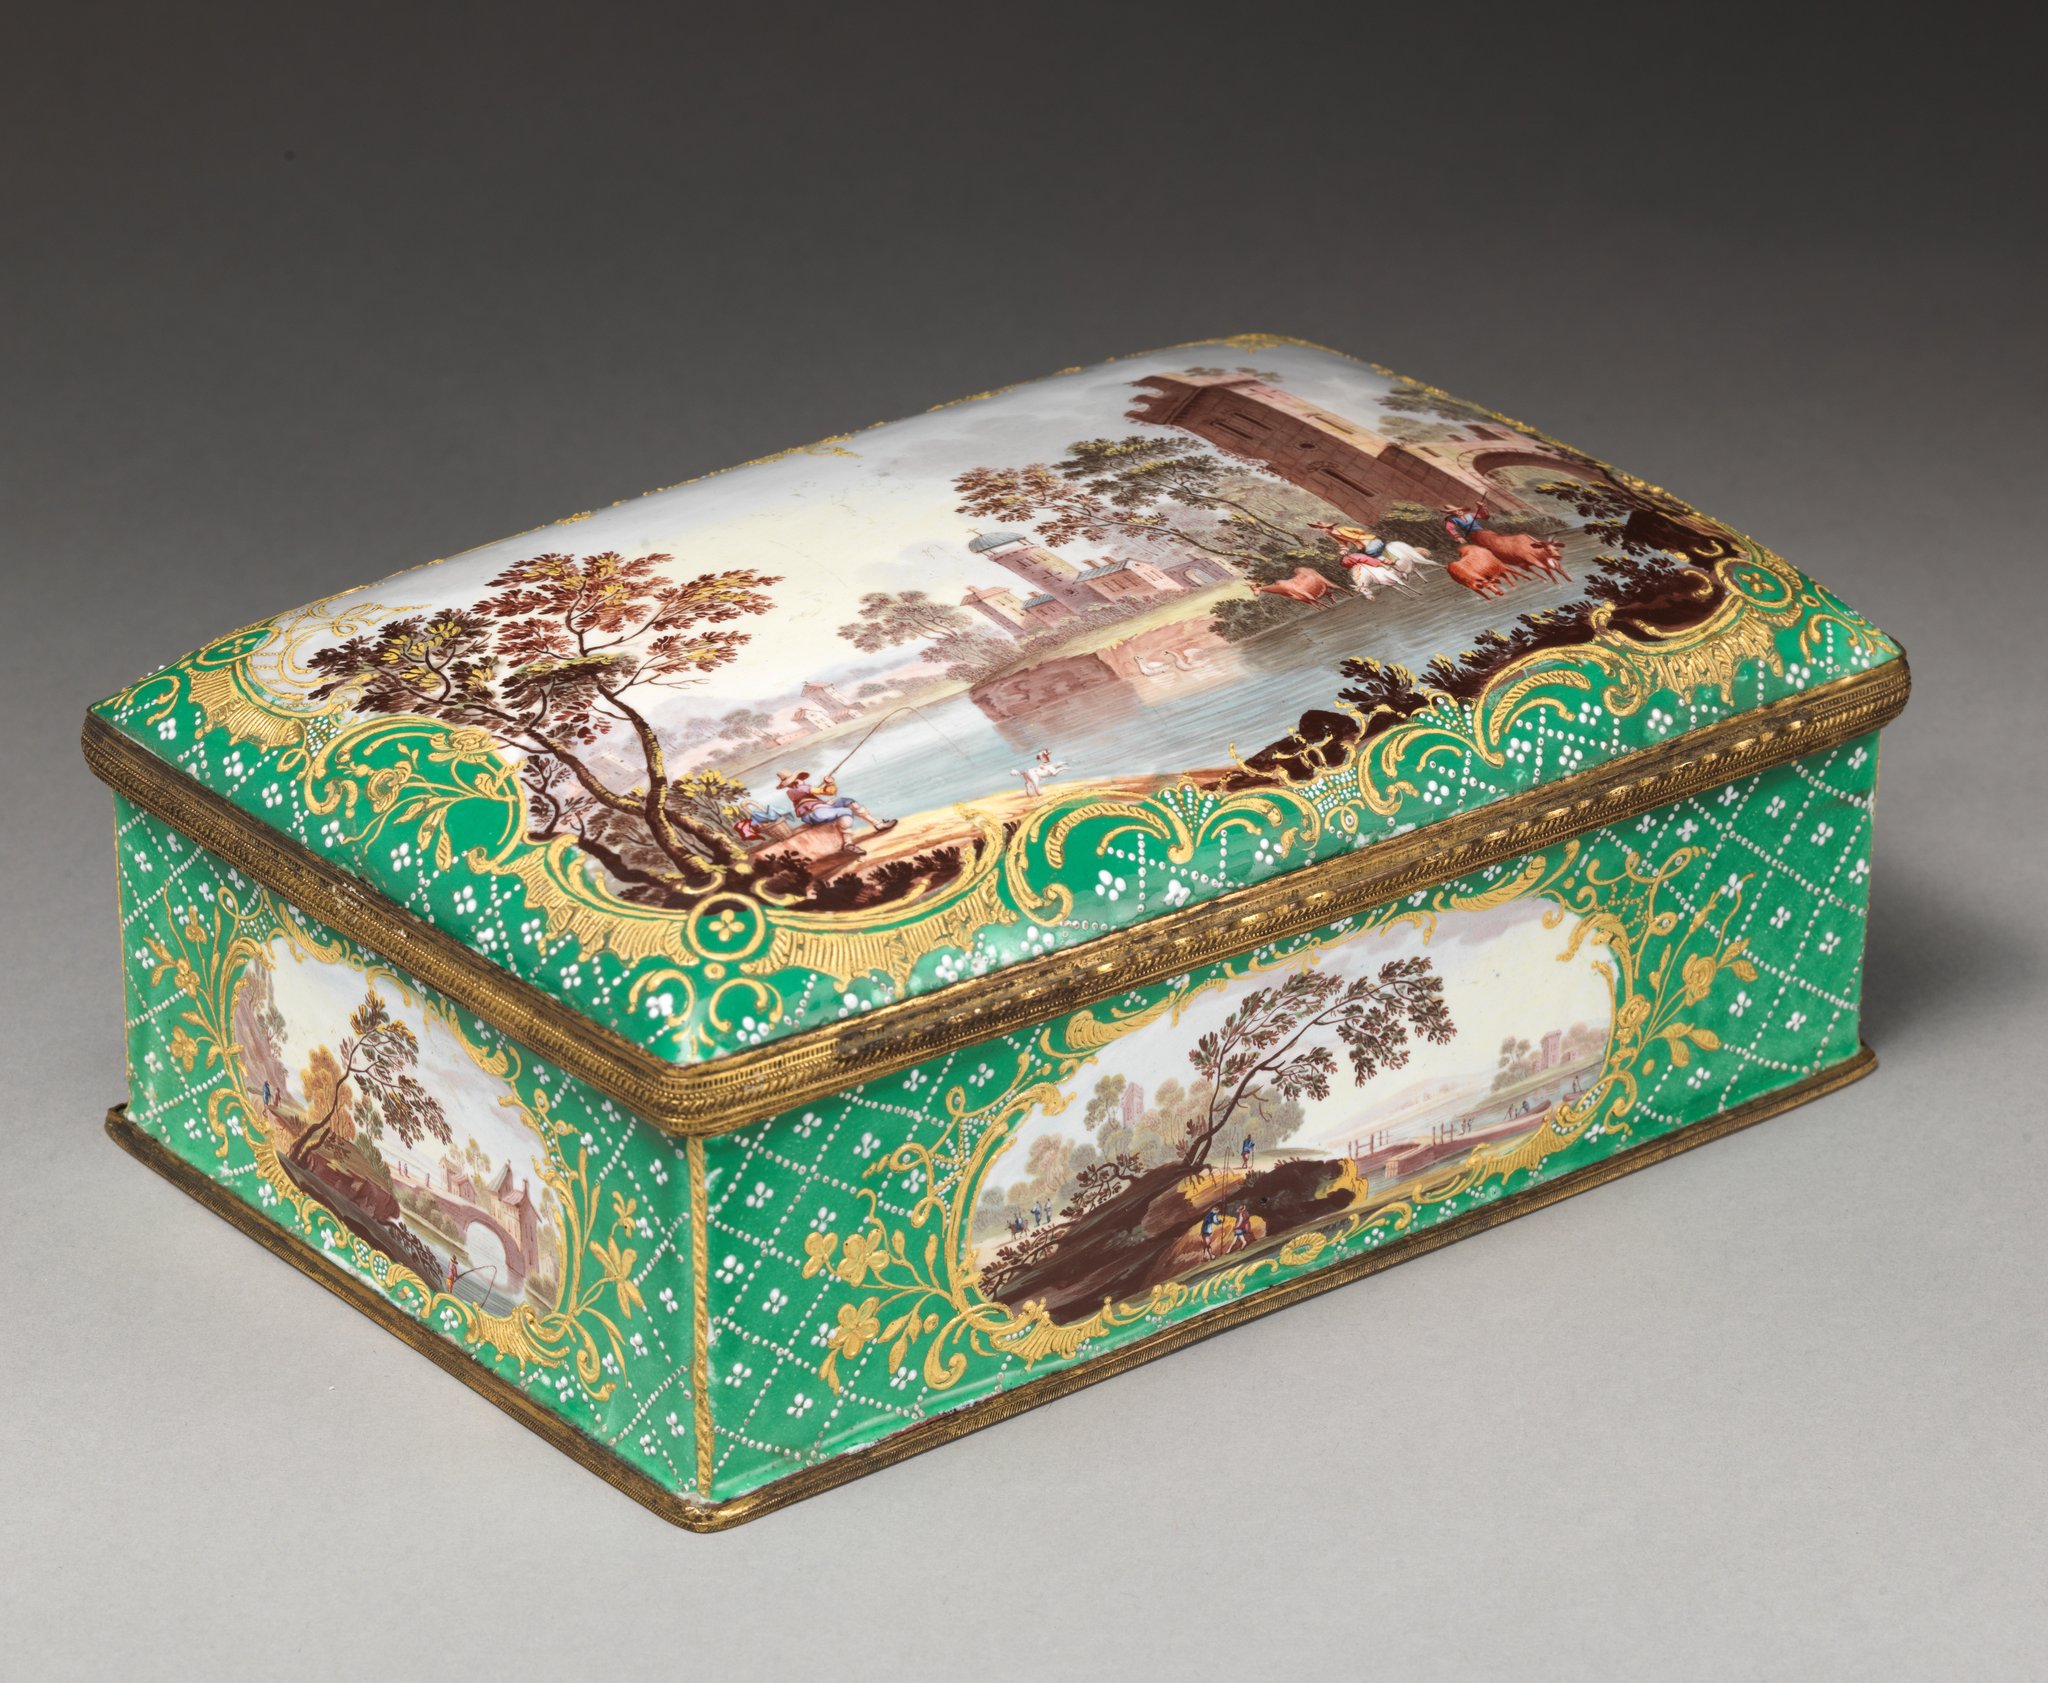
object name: box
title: Toilet box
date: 1765-1770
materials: copper, enamel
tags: fishing,swans,cows,dogs,horses,landscapes